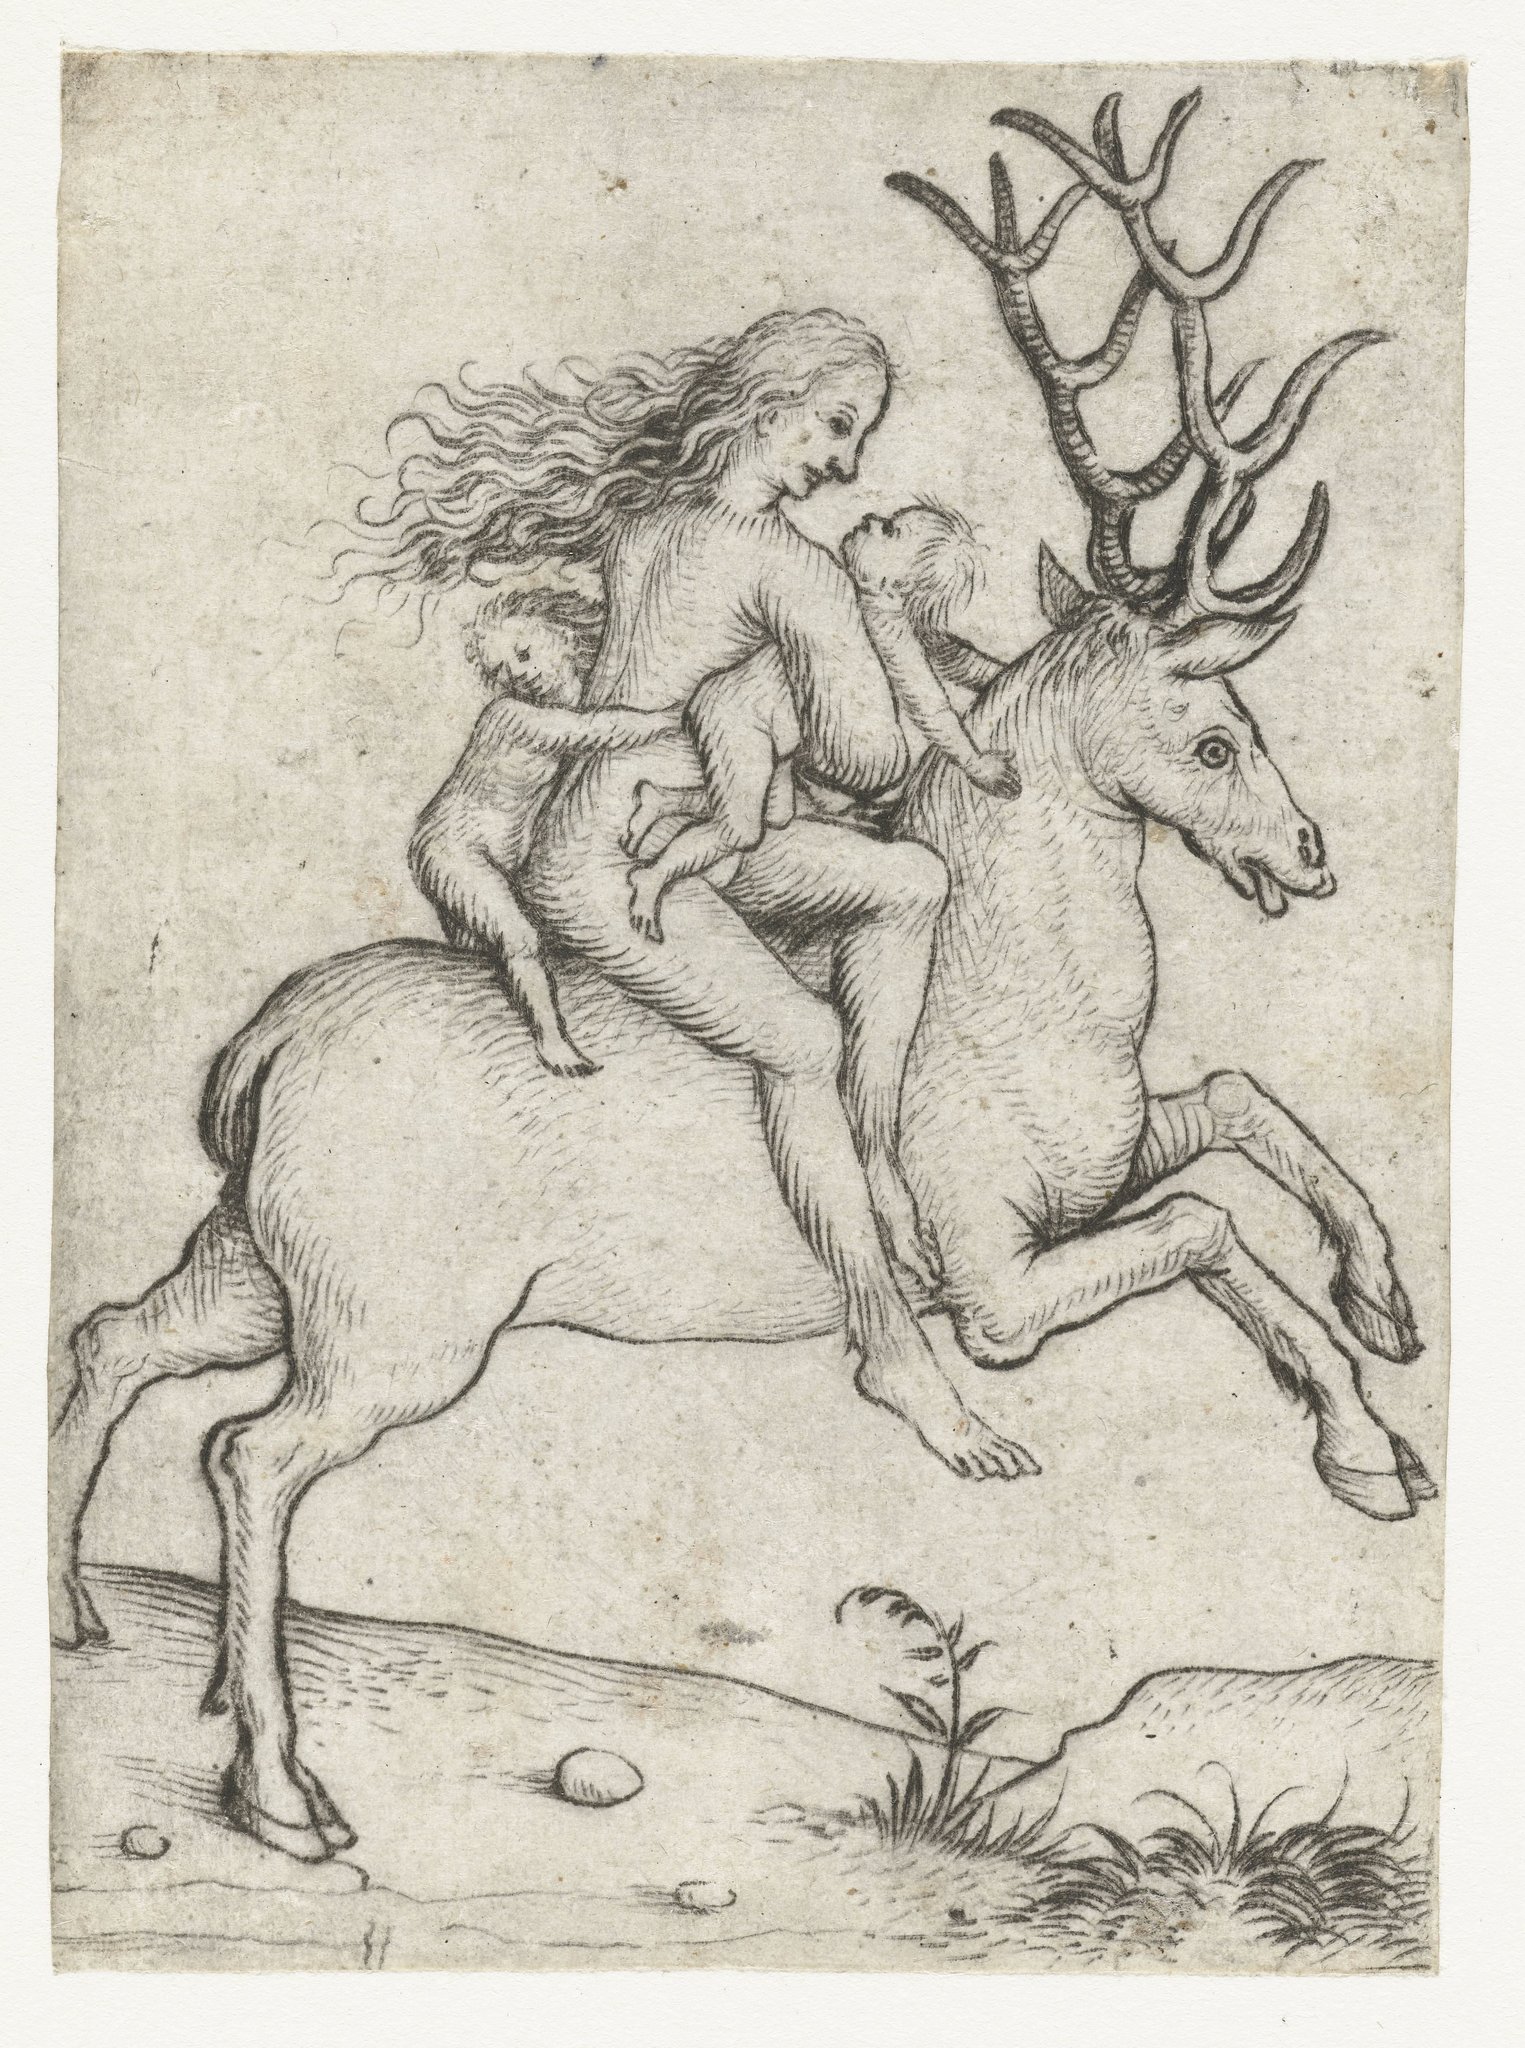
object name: print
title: Wildemans-vrouw met kinderen op een hert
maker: meester van het amsterdamse kabinet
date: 1473-1477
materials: paper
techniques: drypoint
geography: germany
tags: hoofed animals: deer, wild man, wodewose, woodehouse, riding on animal other than horse, ass, or mule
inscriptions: collector's mark: Lugt 2228a